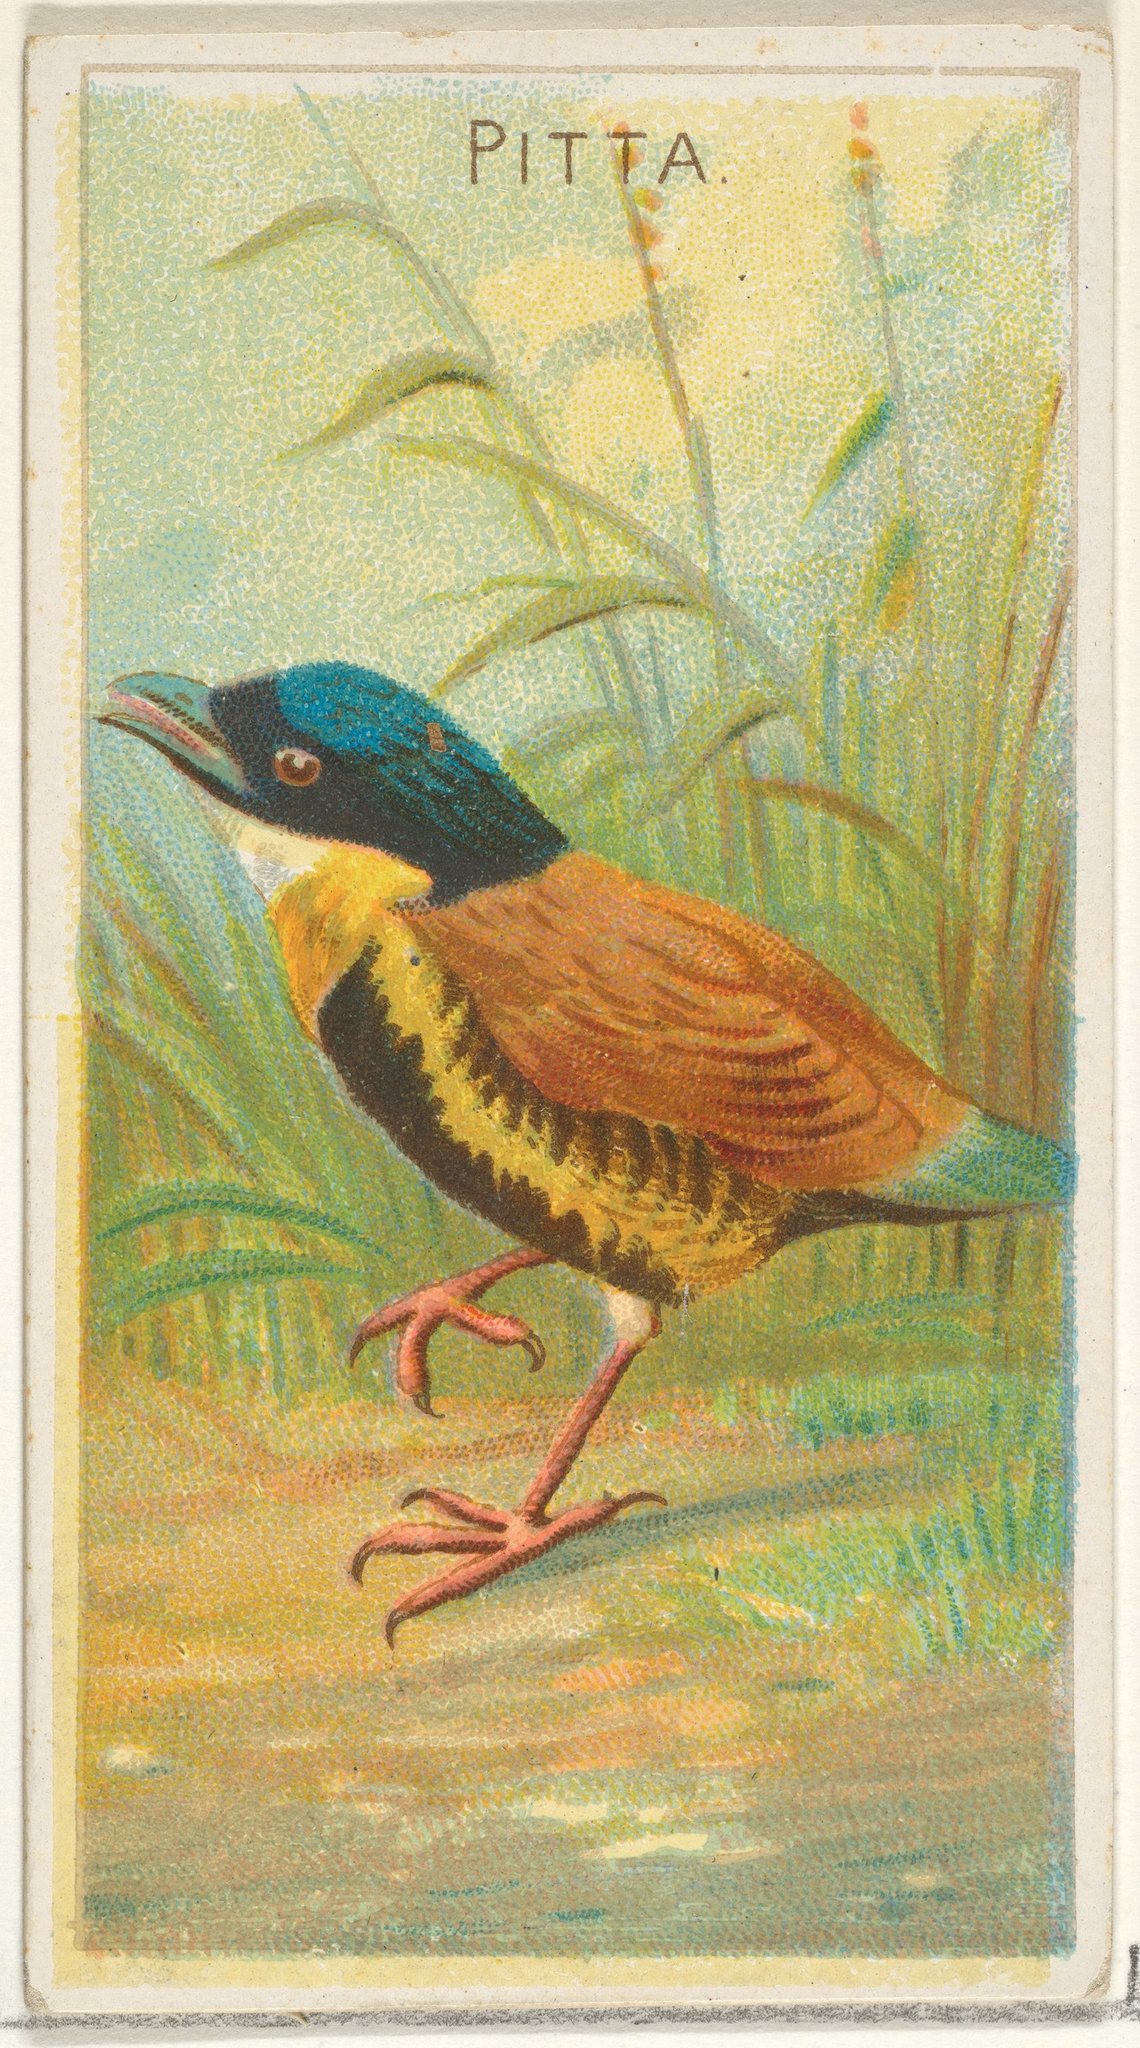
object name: print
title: Pitta, from the Birds of the Tropics series (N5) for Allen & Ginter Cigarettes Brands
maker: allen & ginter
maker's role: publisher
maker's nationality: american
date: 1889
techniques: color lithograph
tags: birds